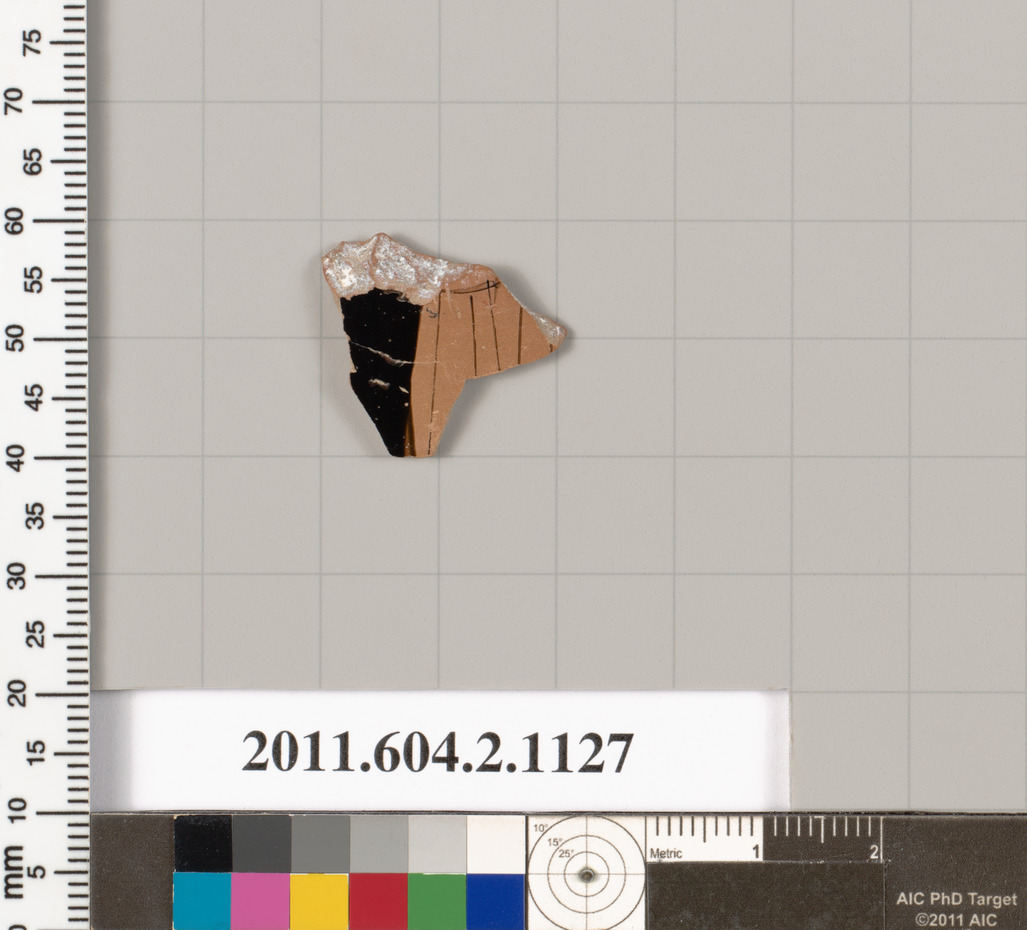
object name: lekythos fragment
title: Terracotta fragment of a lekythos (oil flask)?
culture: greek, attic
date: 470-440 BCE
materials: terracotta